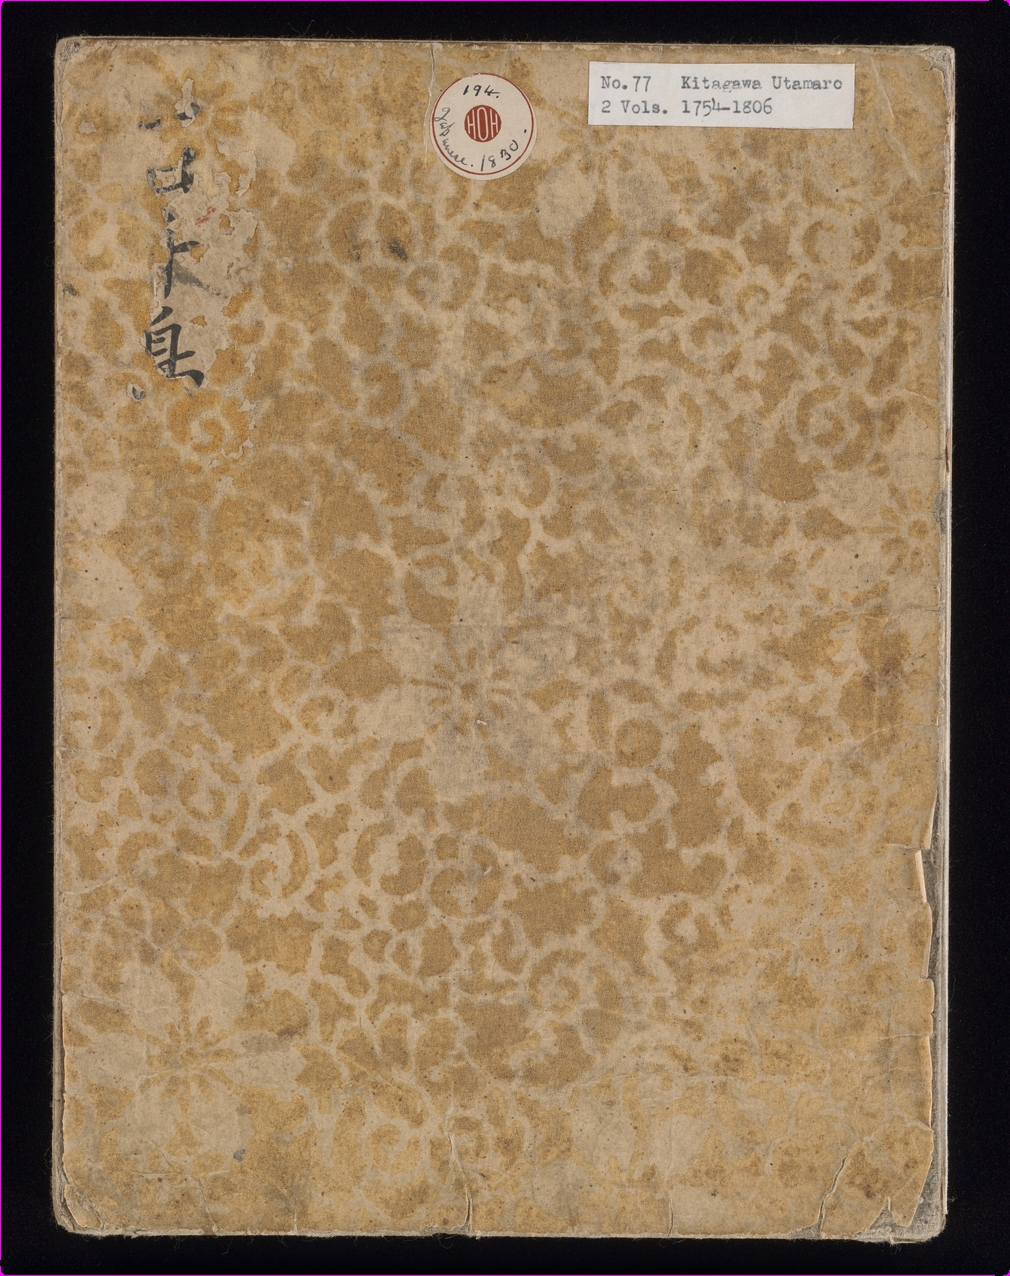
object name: illustrated book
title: Myriad Birds:A Playful Poetry Contest (Momo chidori kyōka-awase), 2 vols.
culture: japanese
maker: kitagawa utamaro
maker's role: artist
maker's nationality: japanese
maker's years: 1754-1806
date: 1790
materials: ink, paper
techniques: woodblock print